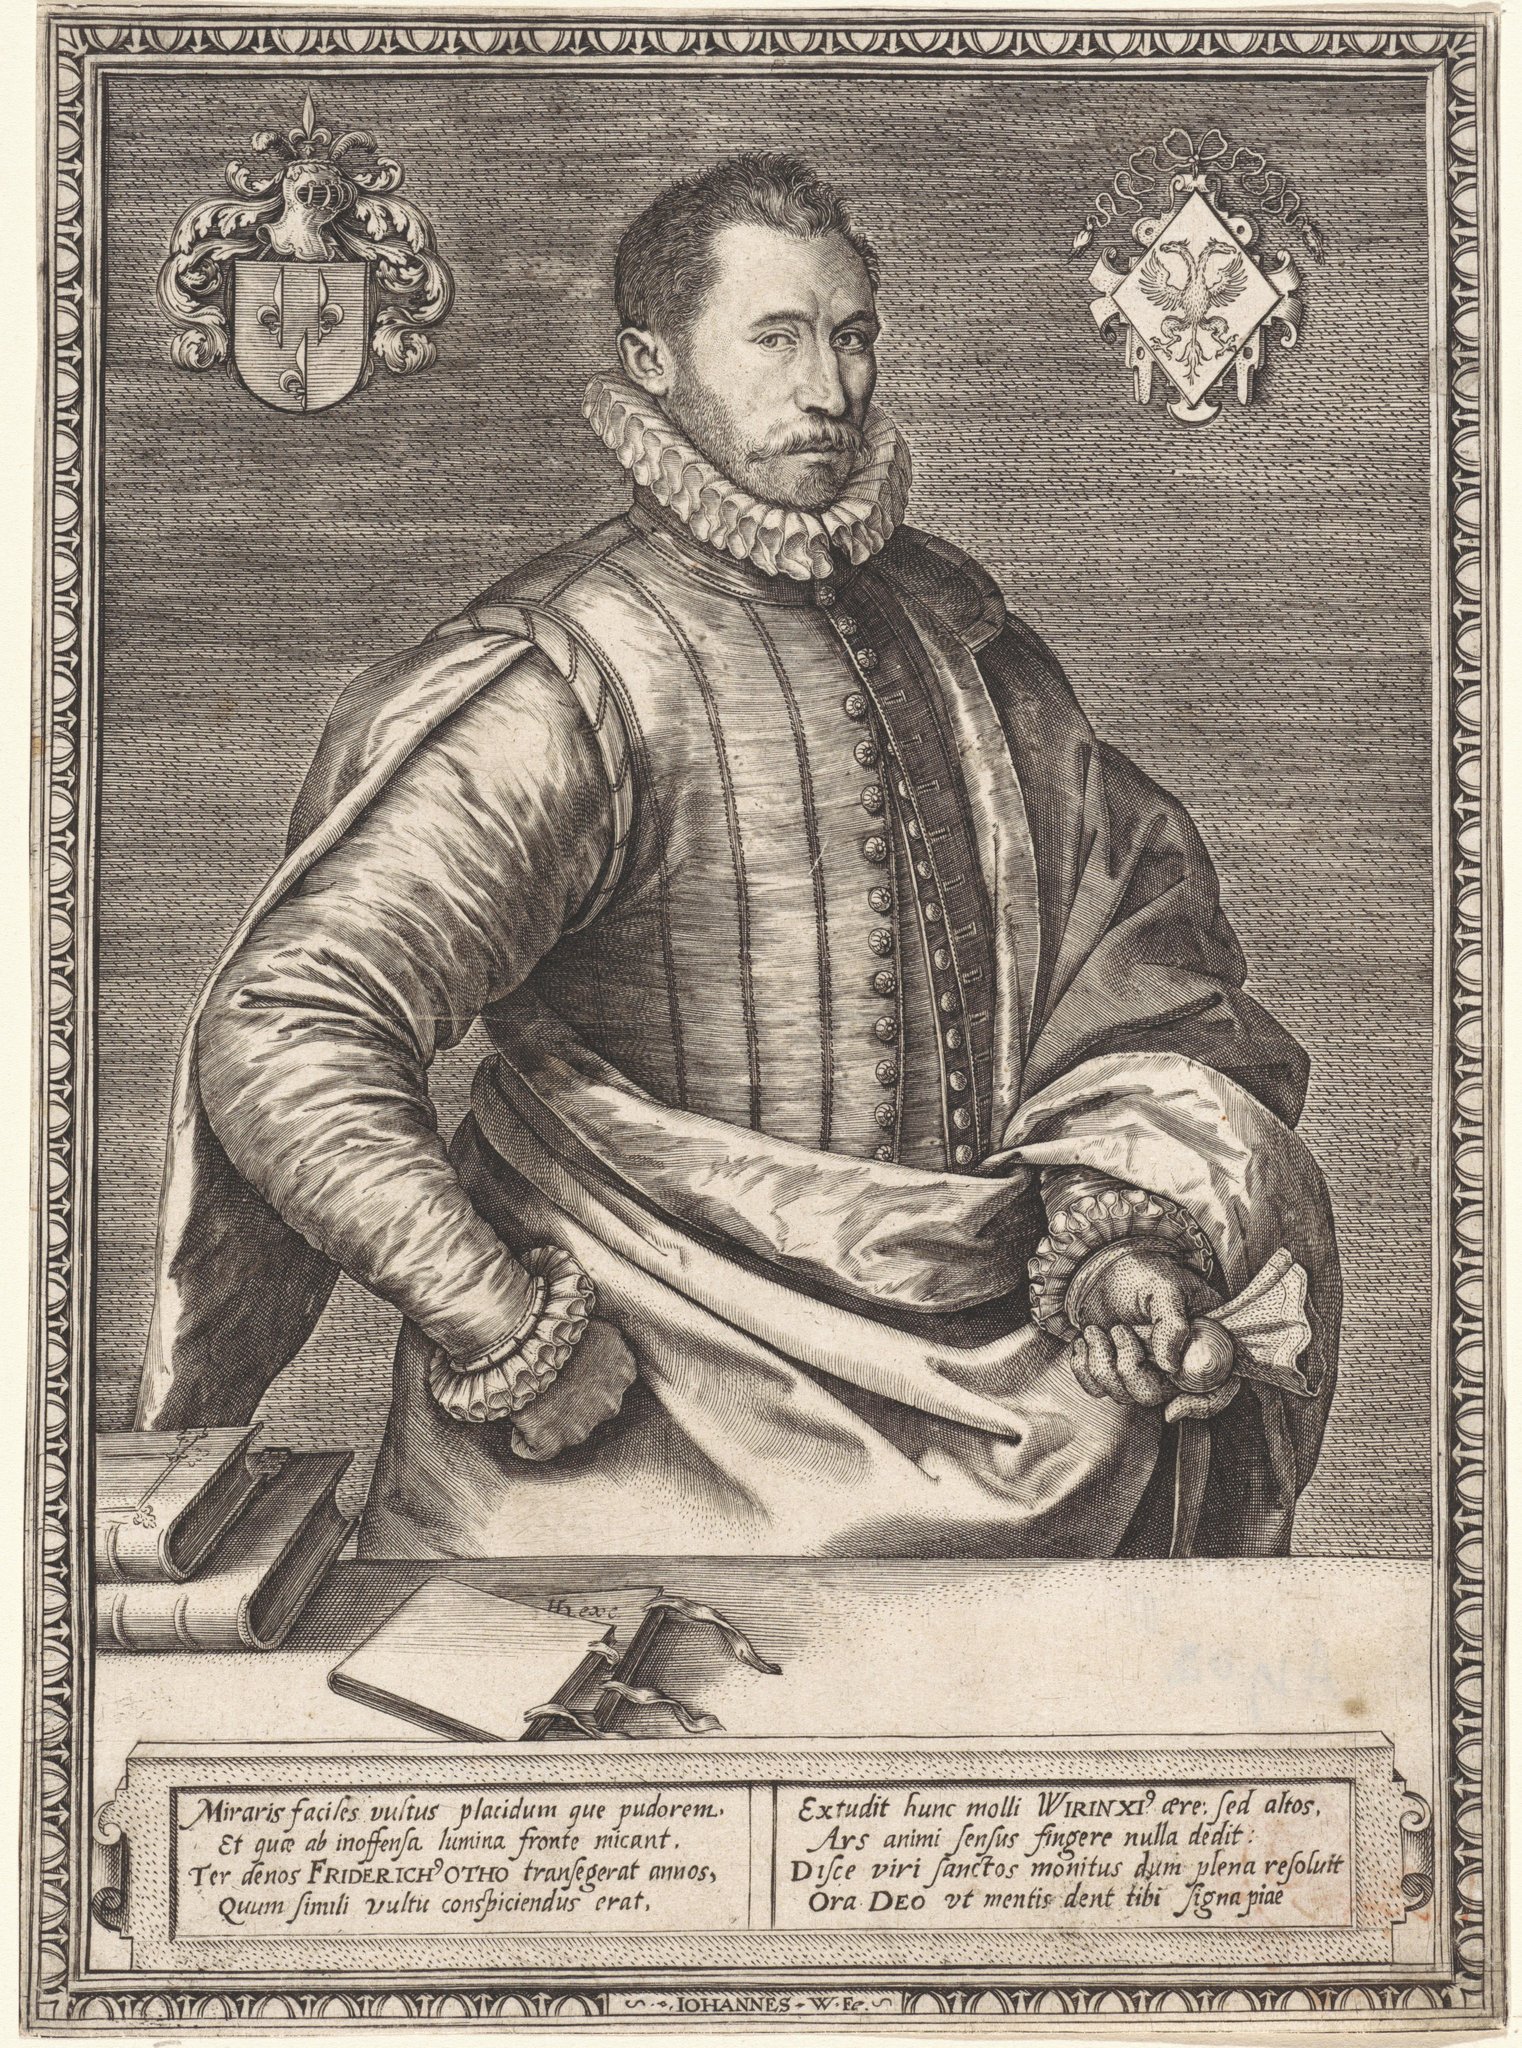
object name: print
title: Portret van prins Frederik Otto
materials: paper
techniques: engraving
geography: antwerp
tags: fruits: apple, gloves, mittens, etc., book, armorial bearing, heraldry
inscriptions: number: ‘22. - 43,b.’, collector's mark: Lugt 240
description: Portret van prins Frederik Otto. Hij heeft een appel en een paar handschoenen in de hand. In de bovenhoeken twee wapenschilden. In het kader een achtregelig onderschrift, in twee kolommen, in het Latijn.